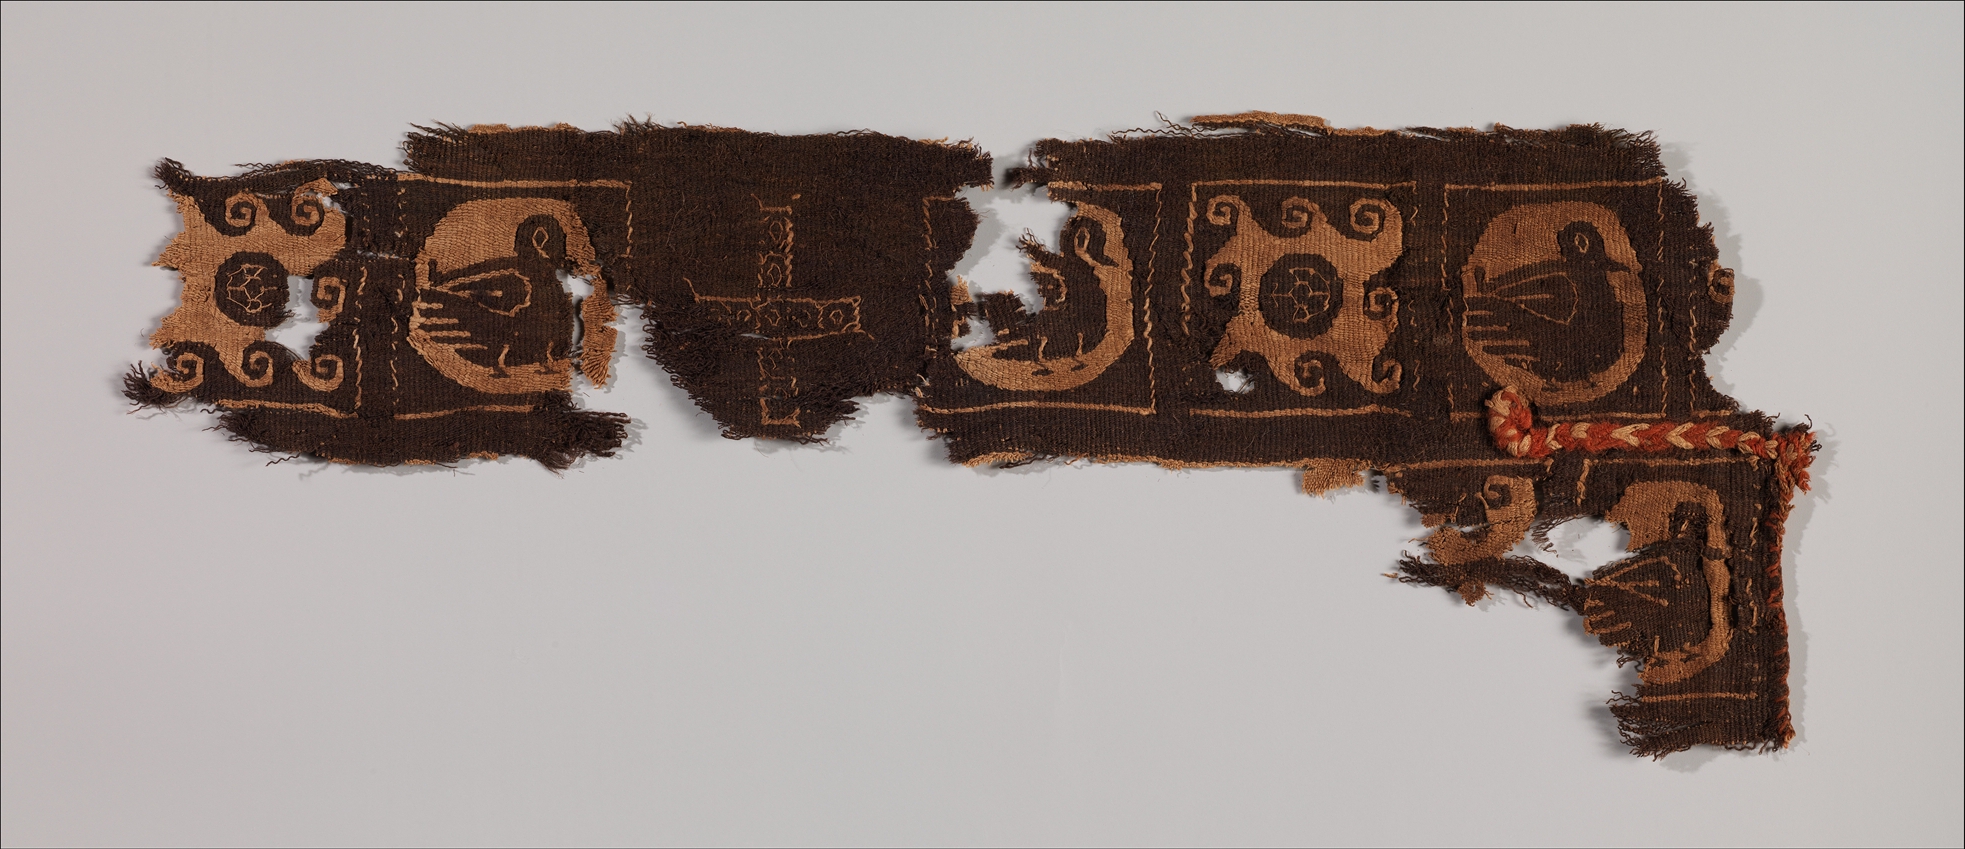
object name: textile fragment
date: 301-400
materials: linen, wool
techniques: weave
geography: egypt